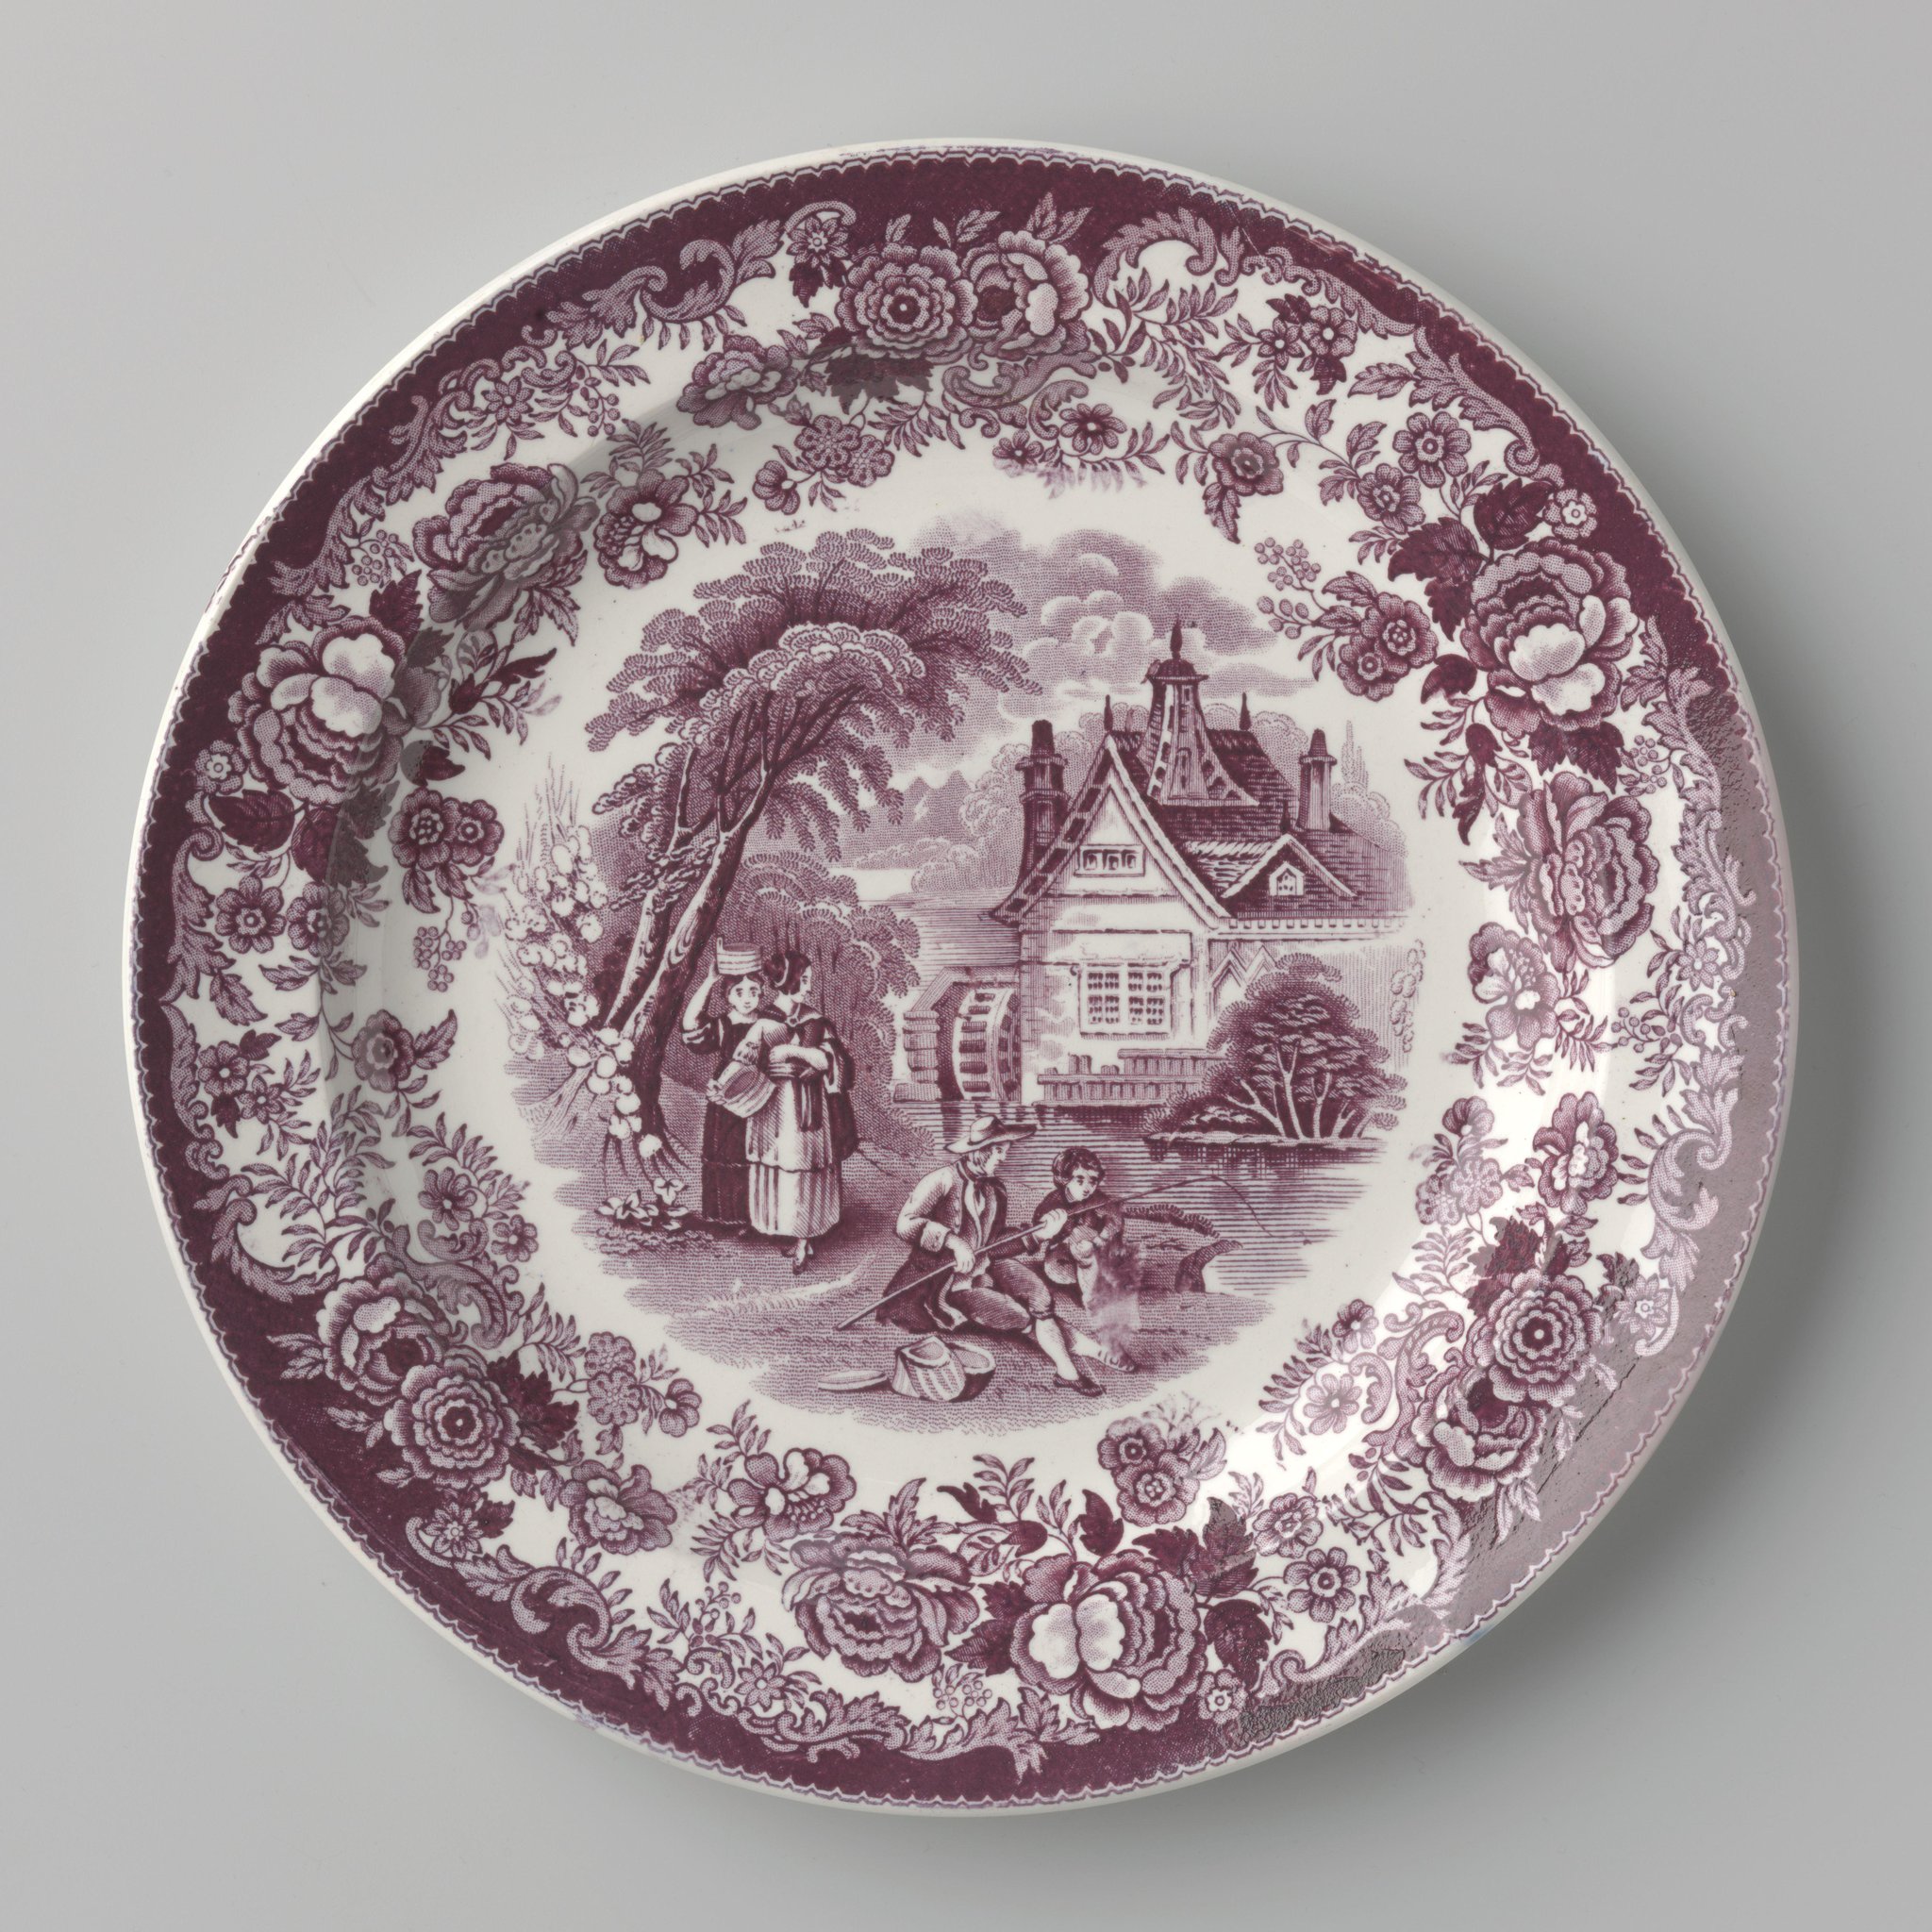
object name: plate dish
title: Bord, met op het plat vissers voor een watermolen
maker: petrus regout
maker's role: plateelbakker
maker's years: 1801-1879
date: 1865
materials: creamware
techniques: transfer decoration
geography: maastricht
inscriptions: mark: ‘MILLER // MAASTRICHT // PETRUS REGOUT en 6 25’, check stamp: ‘P. REGOUT // 13 // MAASTRICHT’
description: Bord van aardewerk met lila transferdecor. Op het plat twee vrouwen en vissers voor een watermolen. De rands is gedecoreerd met bloemen.